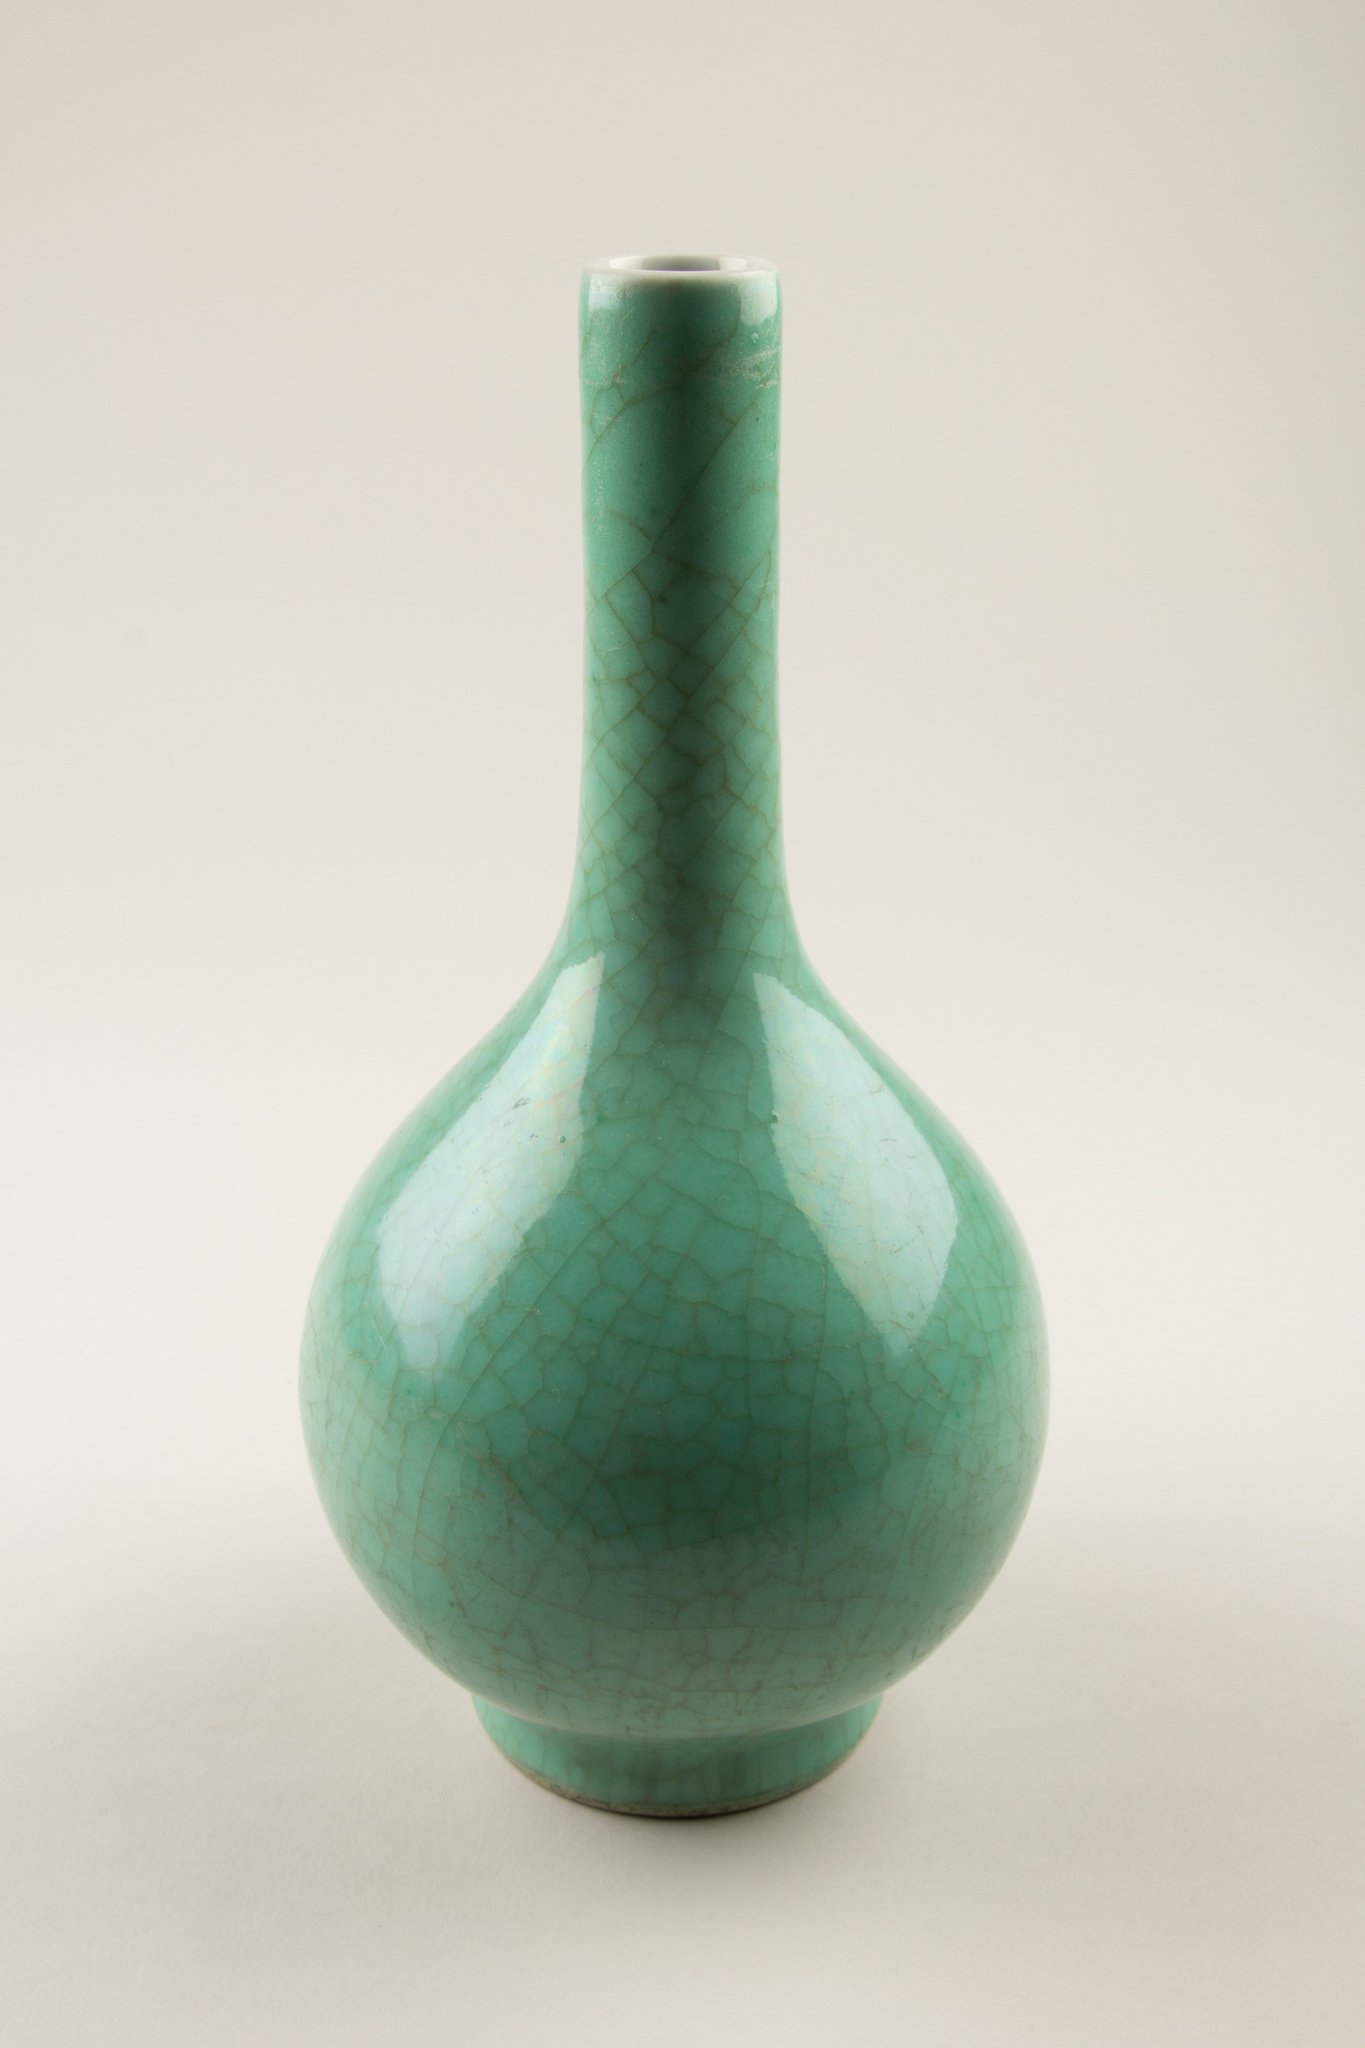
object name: bottle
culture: chinese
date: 1662-1772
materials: porcelain